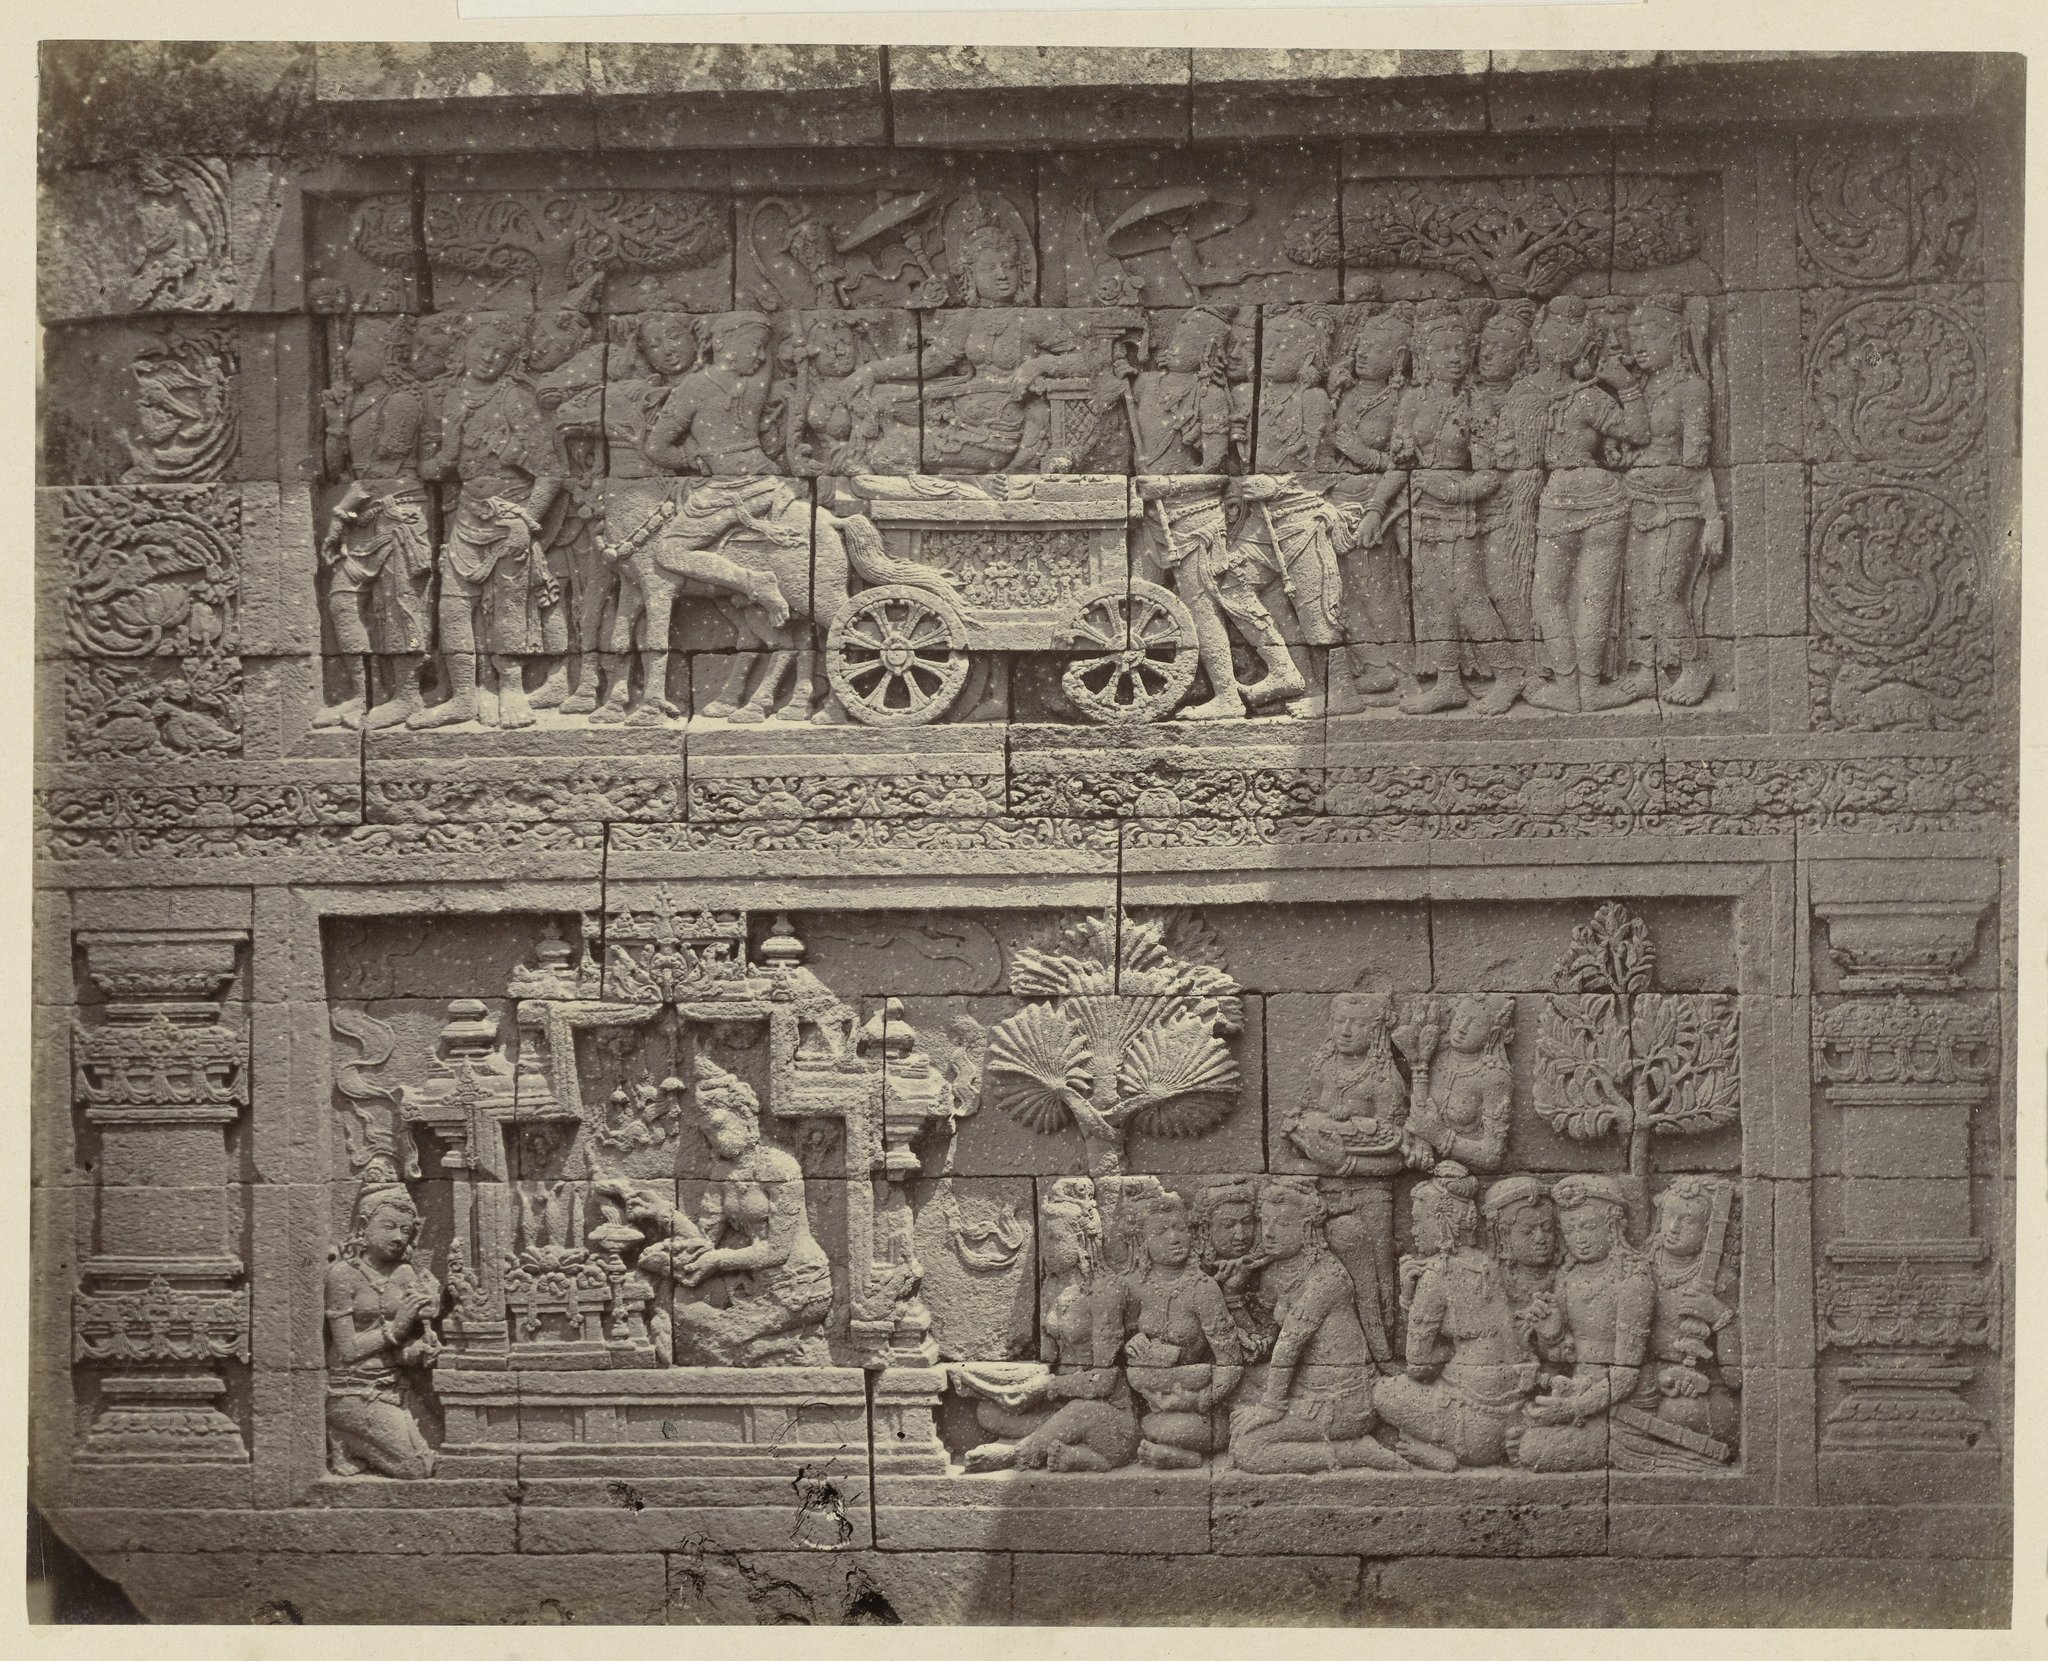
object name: photograph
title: Idem 2e gaanderij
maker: isidore kinsbergen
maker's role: fotograaf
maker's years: 1821-1905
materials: cardboard, paper, photographic support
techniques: albumen print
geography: java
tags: borobudur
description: Gallery I, main wall, south side 23 (top): Relief 1a-27, Lalitavistara relief, Queen Maya on her way to Lumbini park where the delivery of Siddhartha, the future Buddha took place. 24 (bottom): relief 1b-27, Avadana relief, unidentified offering scene. Borobudur village, Magelang district, Central Java province, 778-824 AD.